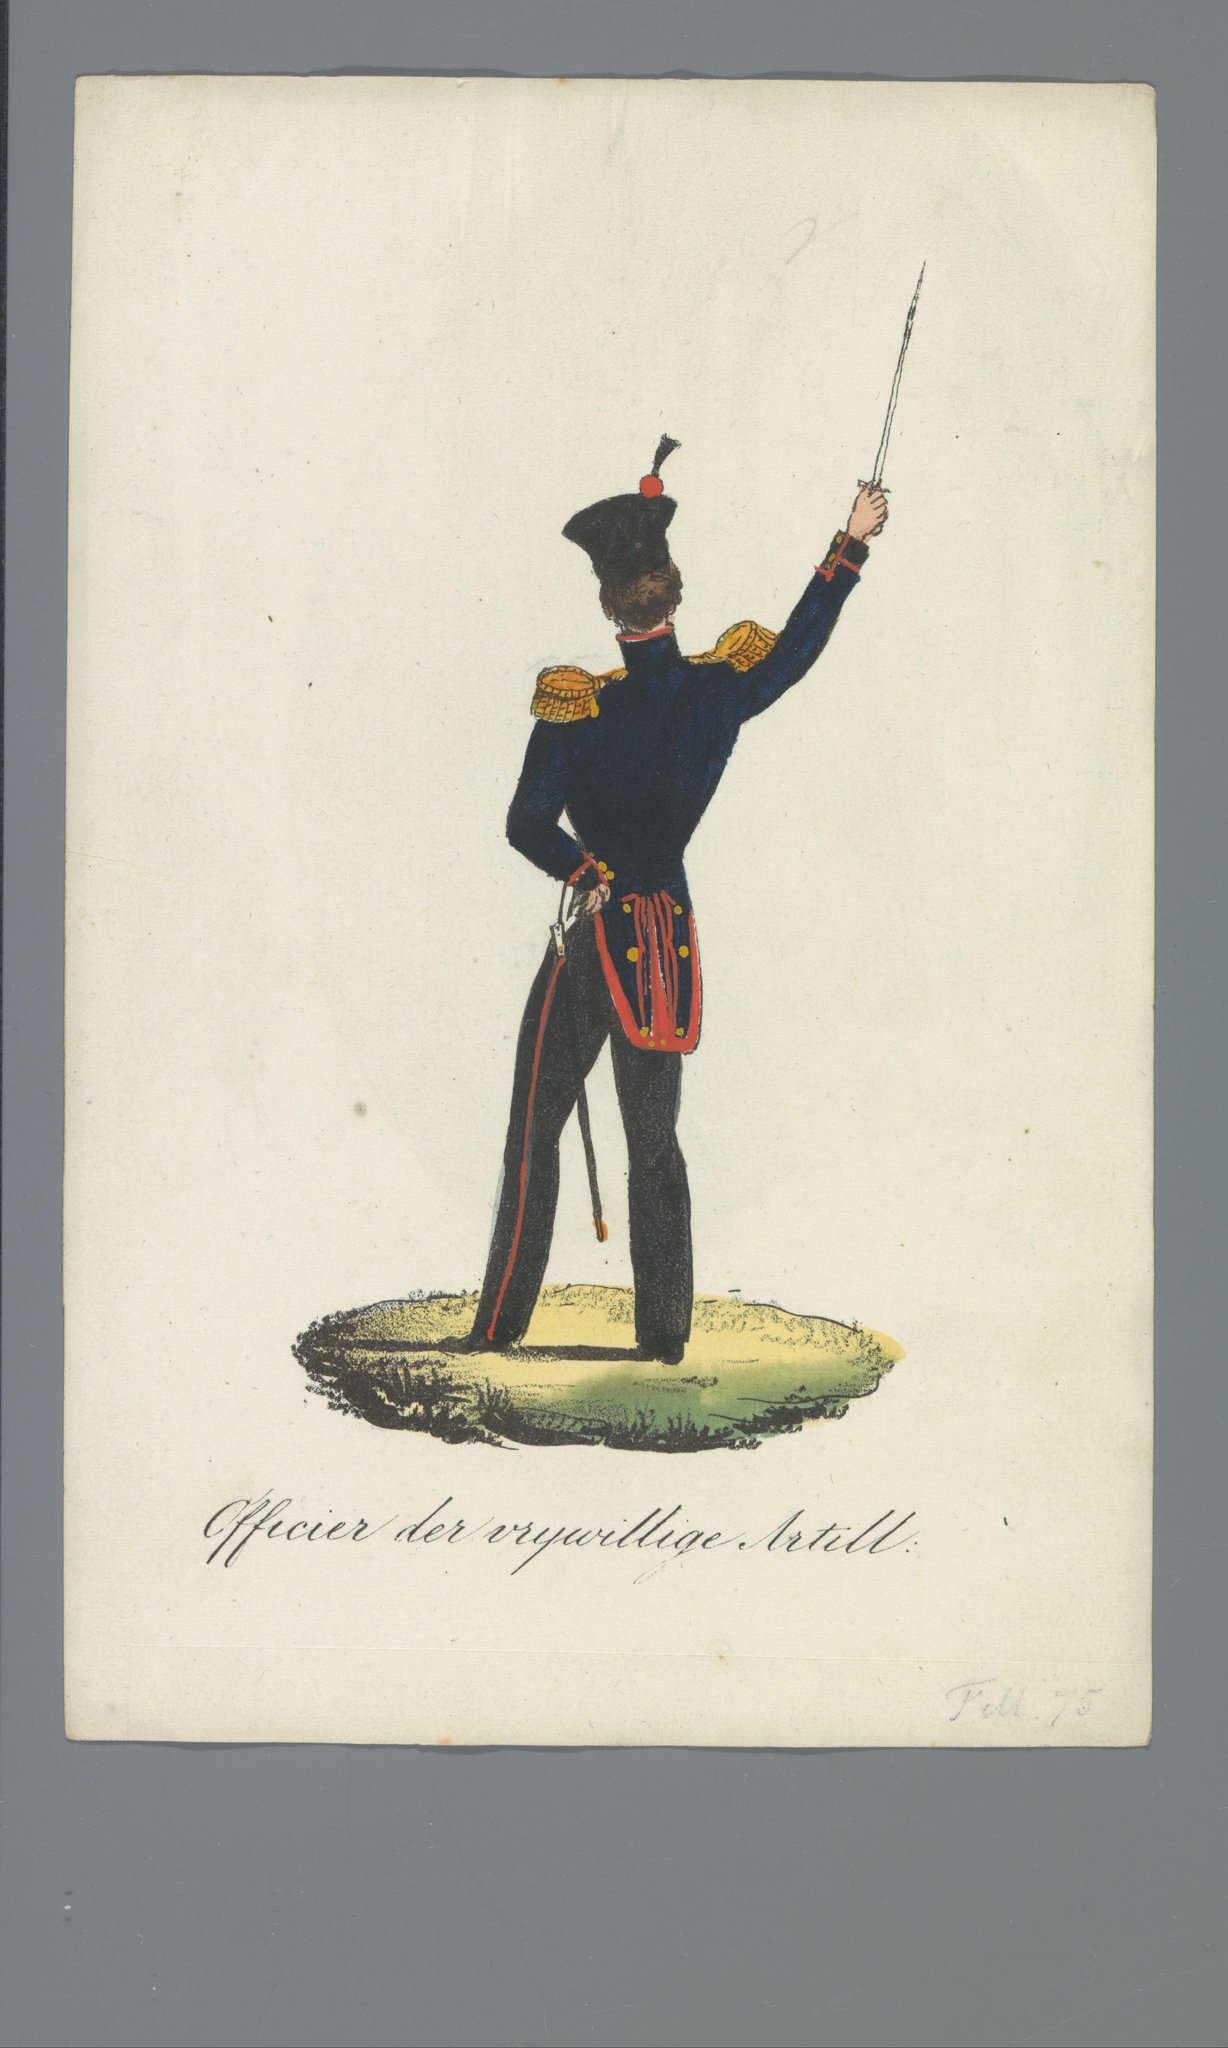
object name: print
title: Officier der vrijwillige Artill:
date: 1835-1850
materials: paper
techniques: hand coloring, lithograph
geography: netherlands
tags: (military) uniforms, clothes, costume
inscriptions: collector's mark: Lugt 2228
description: Staande officier van de vrijwillige artillerie. Onderdeel van een serie van 157 losse bladen met Nederlandse militaire uniformen in de jaren 1830-1832.